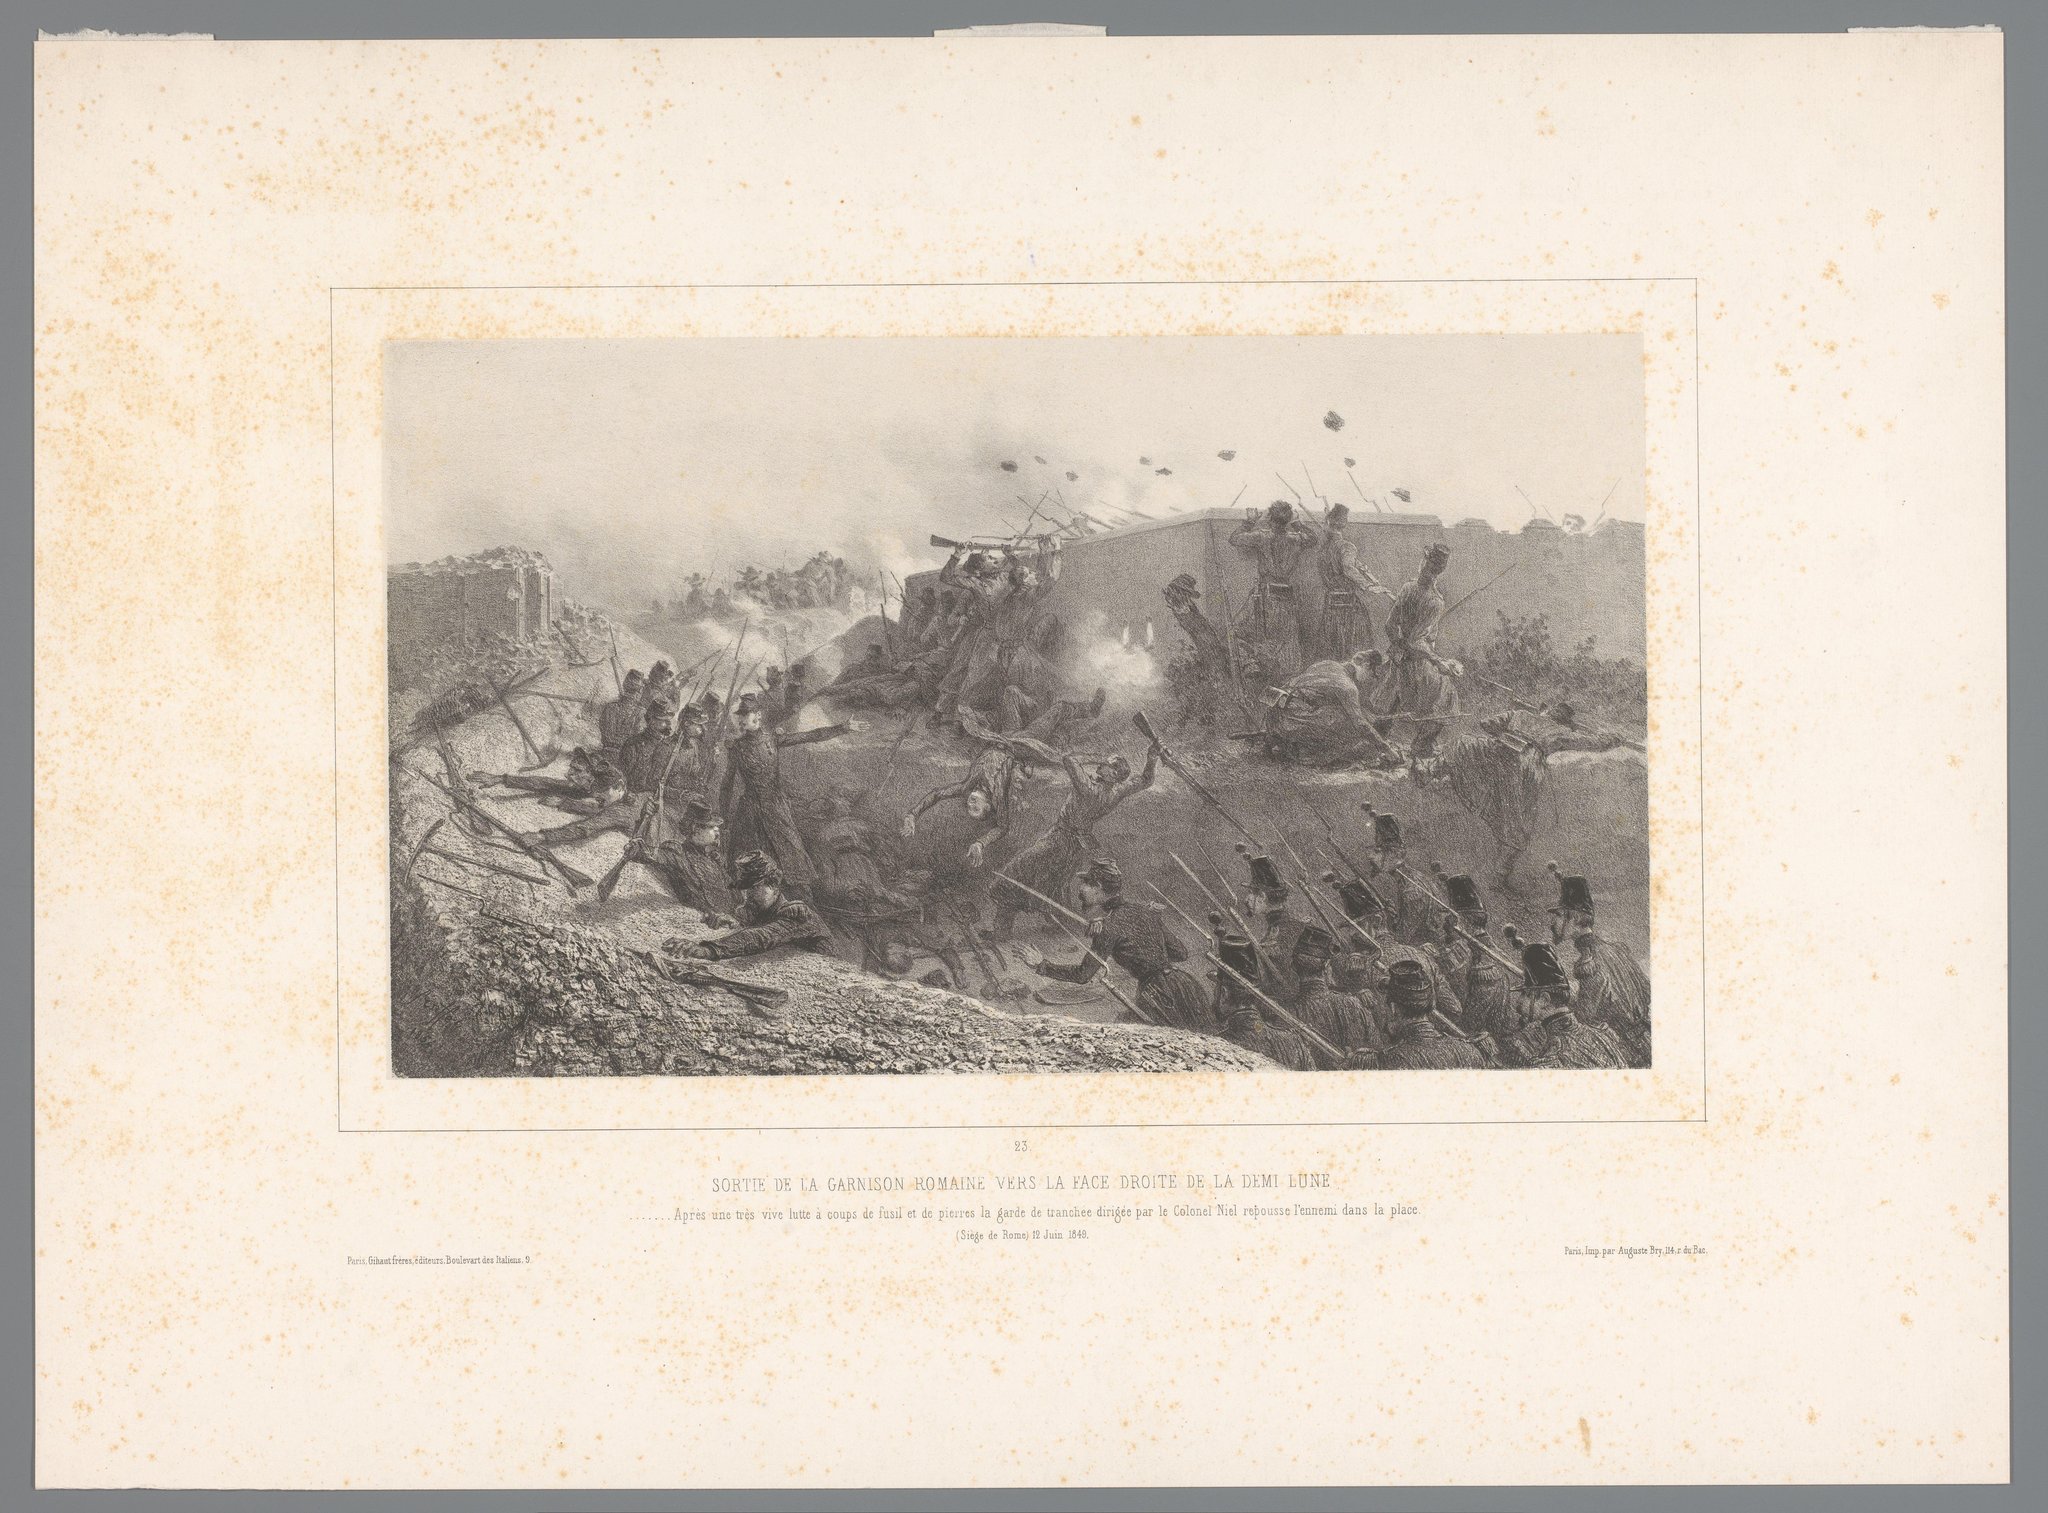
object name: print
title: Expeditie naar en beleg van Rome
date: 1854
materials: paper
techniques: lithograph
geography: paris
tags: battle, the soldier; the soldier's life, trenches, rome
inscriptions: collector's mark: Lugt 2228, collector's mark: Lugt 2760